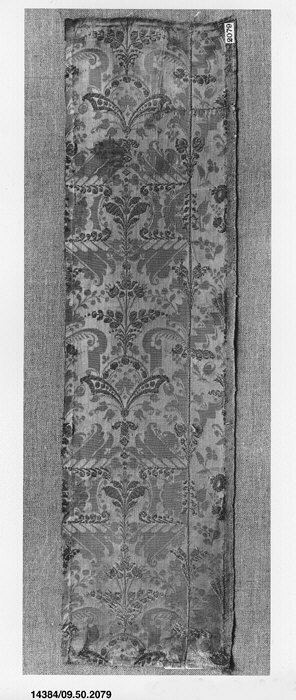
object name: piece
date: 1701-1733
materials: metal thread, silk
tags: leaves